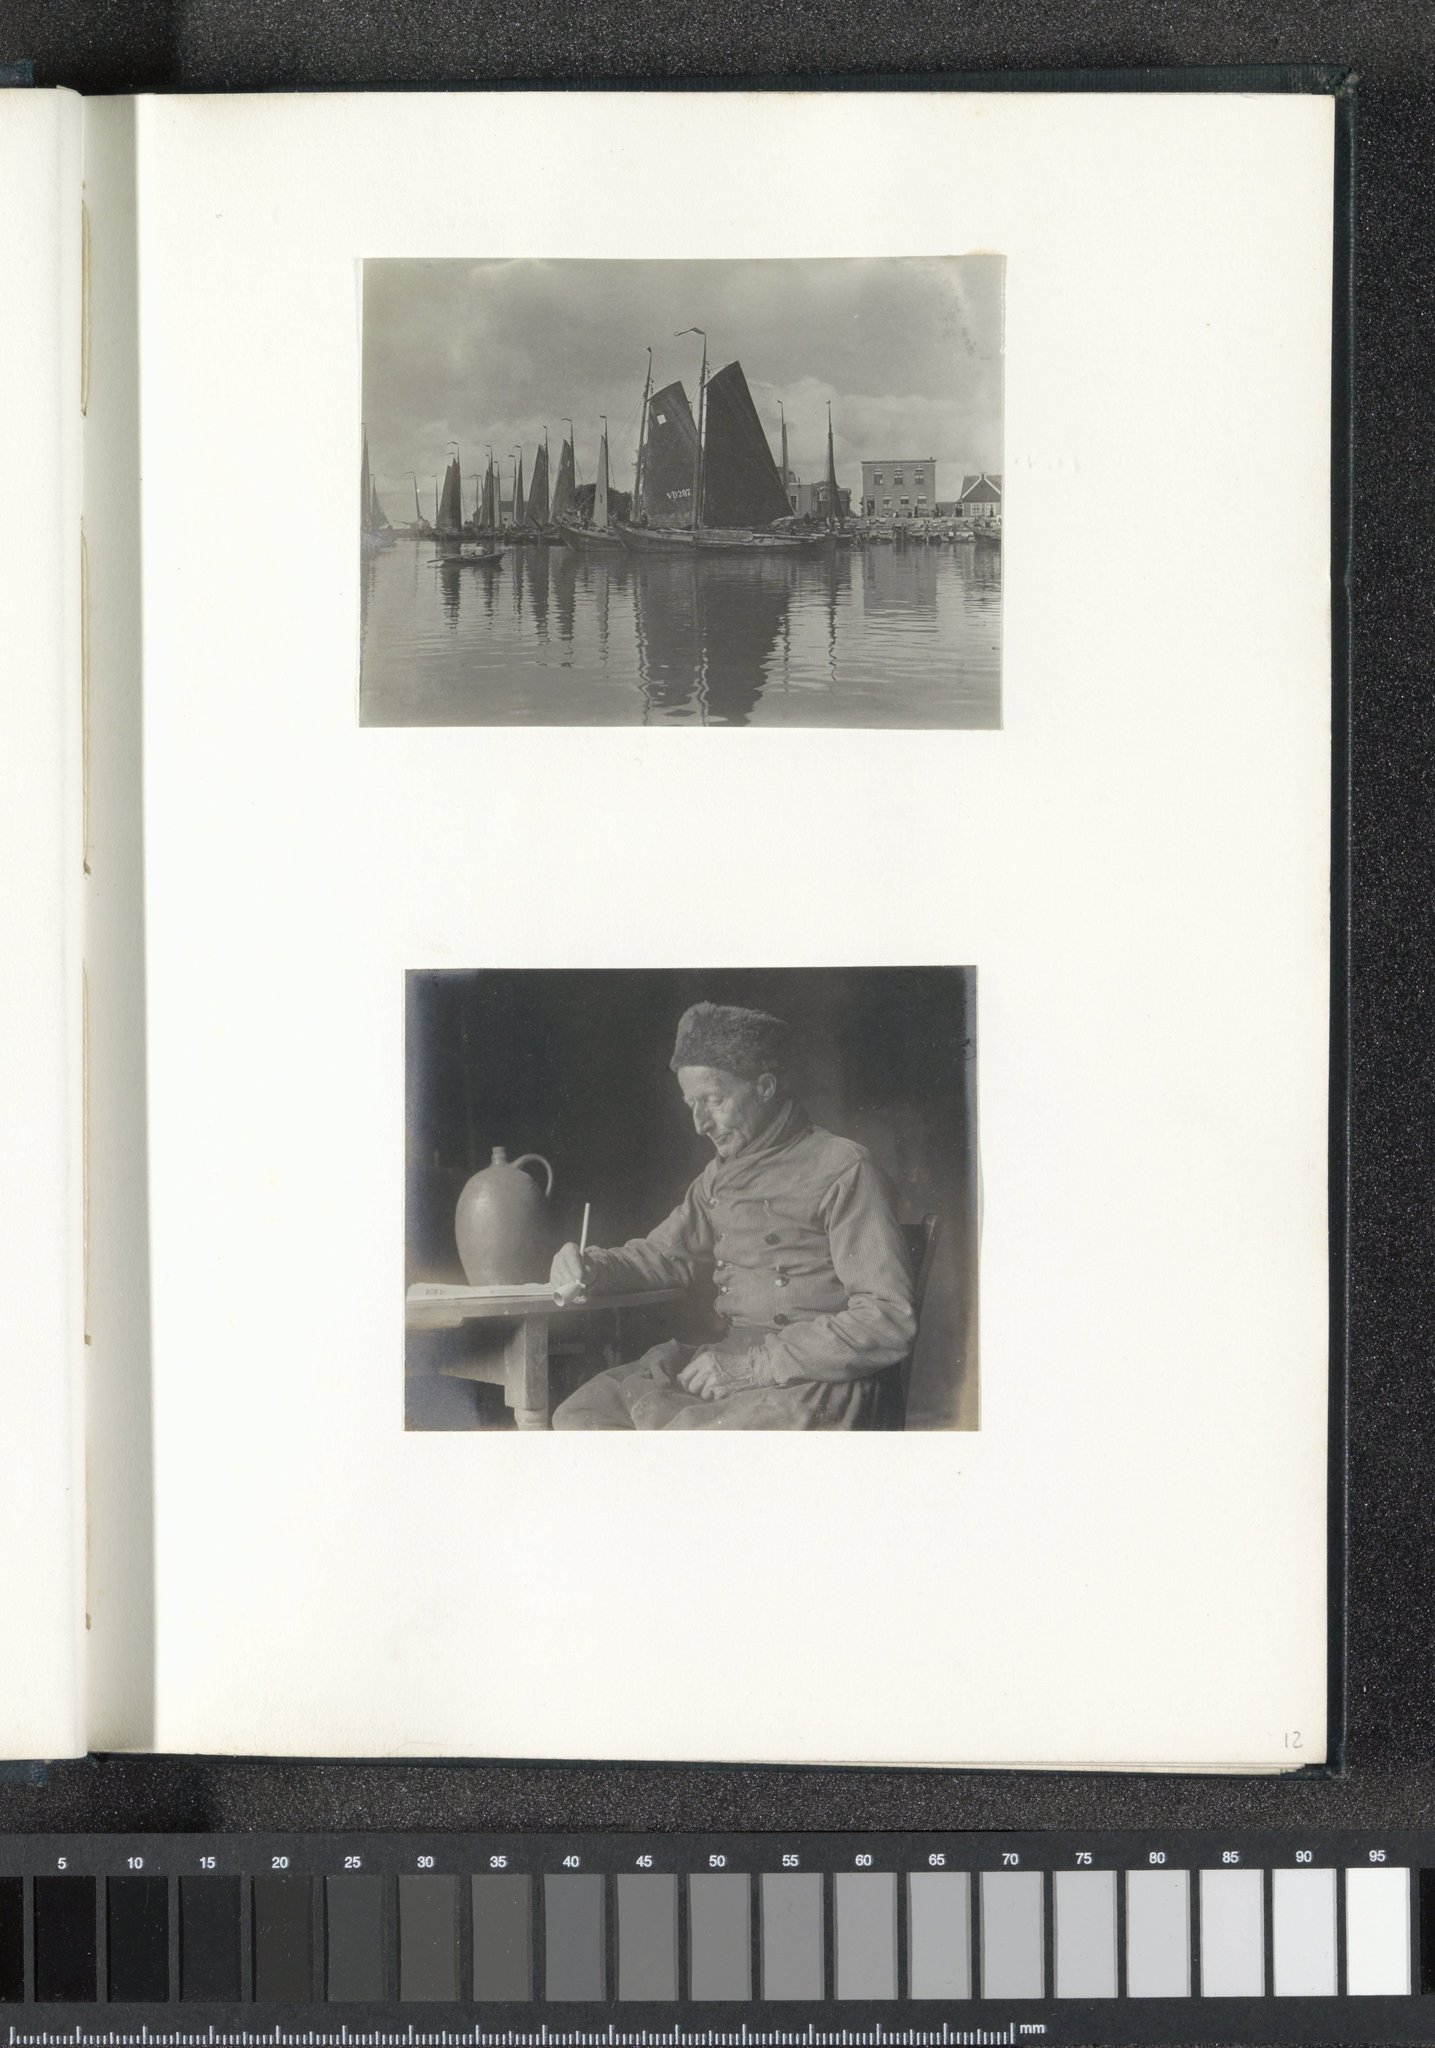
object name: photograph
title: Vissersschepen in de haven van Volendam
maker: george hidderley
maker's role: fotograaf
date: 1900-1910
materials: paper, photographic support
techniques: gelatin silver print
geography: volendam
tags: sailing-ship, sailing-boat, harbour (+ view ~ vehicle, ship, etc.)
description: Onderdeel van fotoalbum met opnames van Volendam, Dordrecht, Gorinchem en Woudrichem.